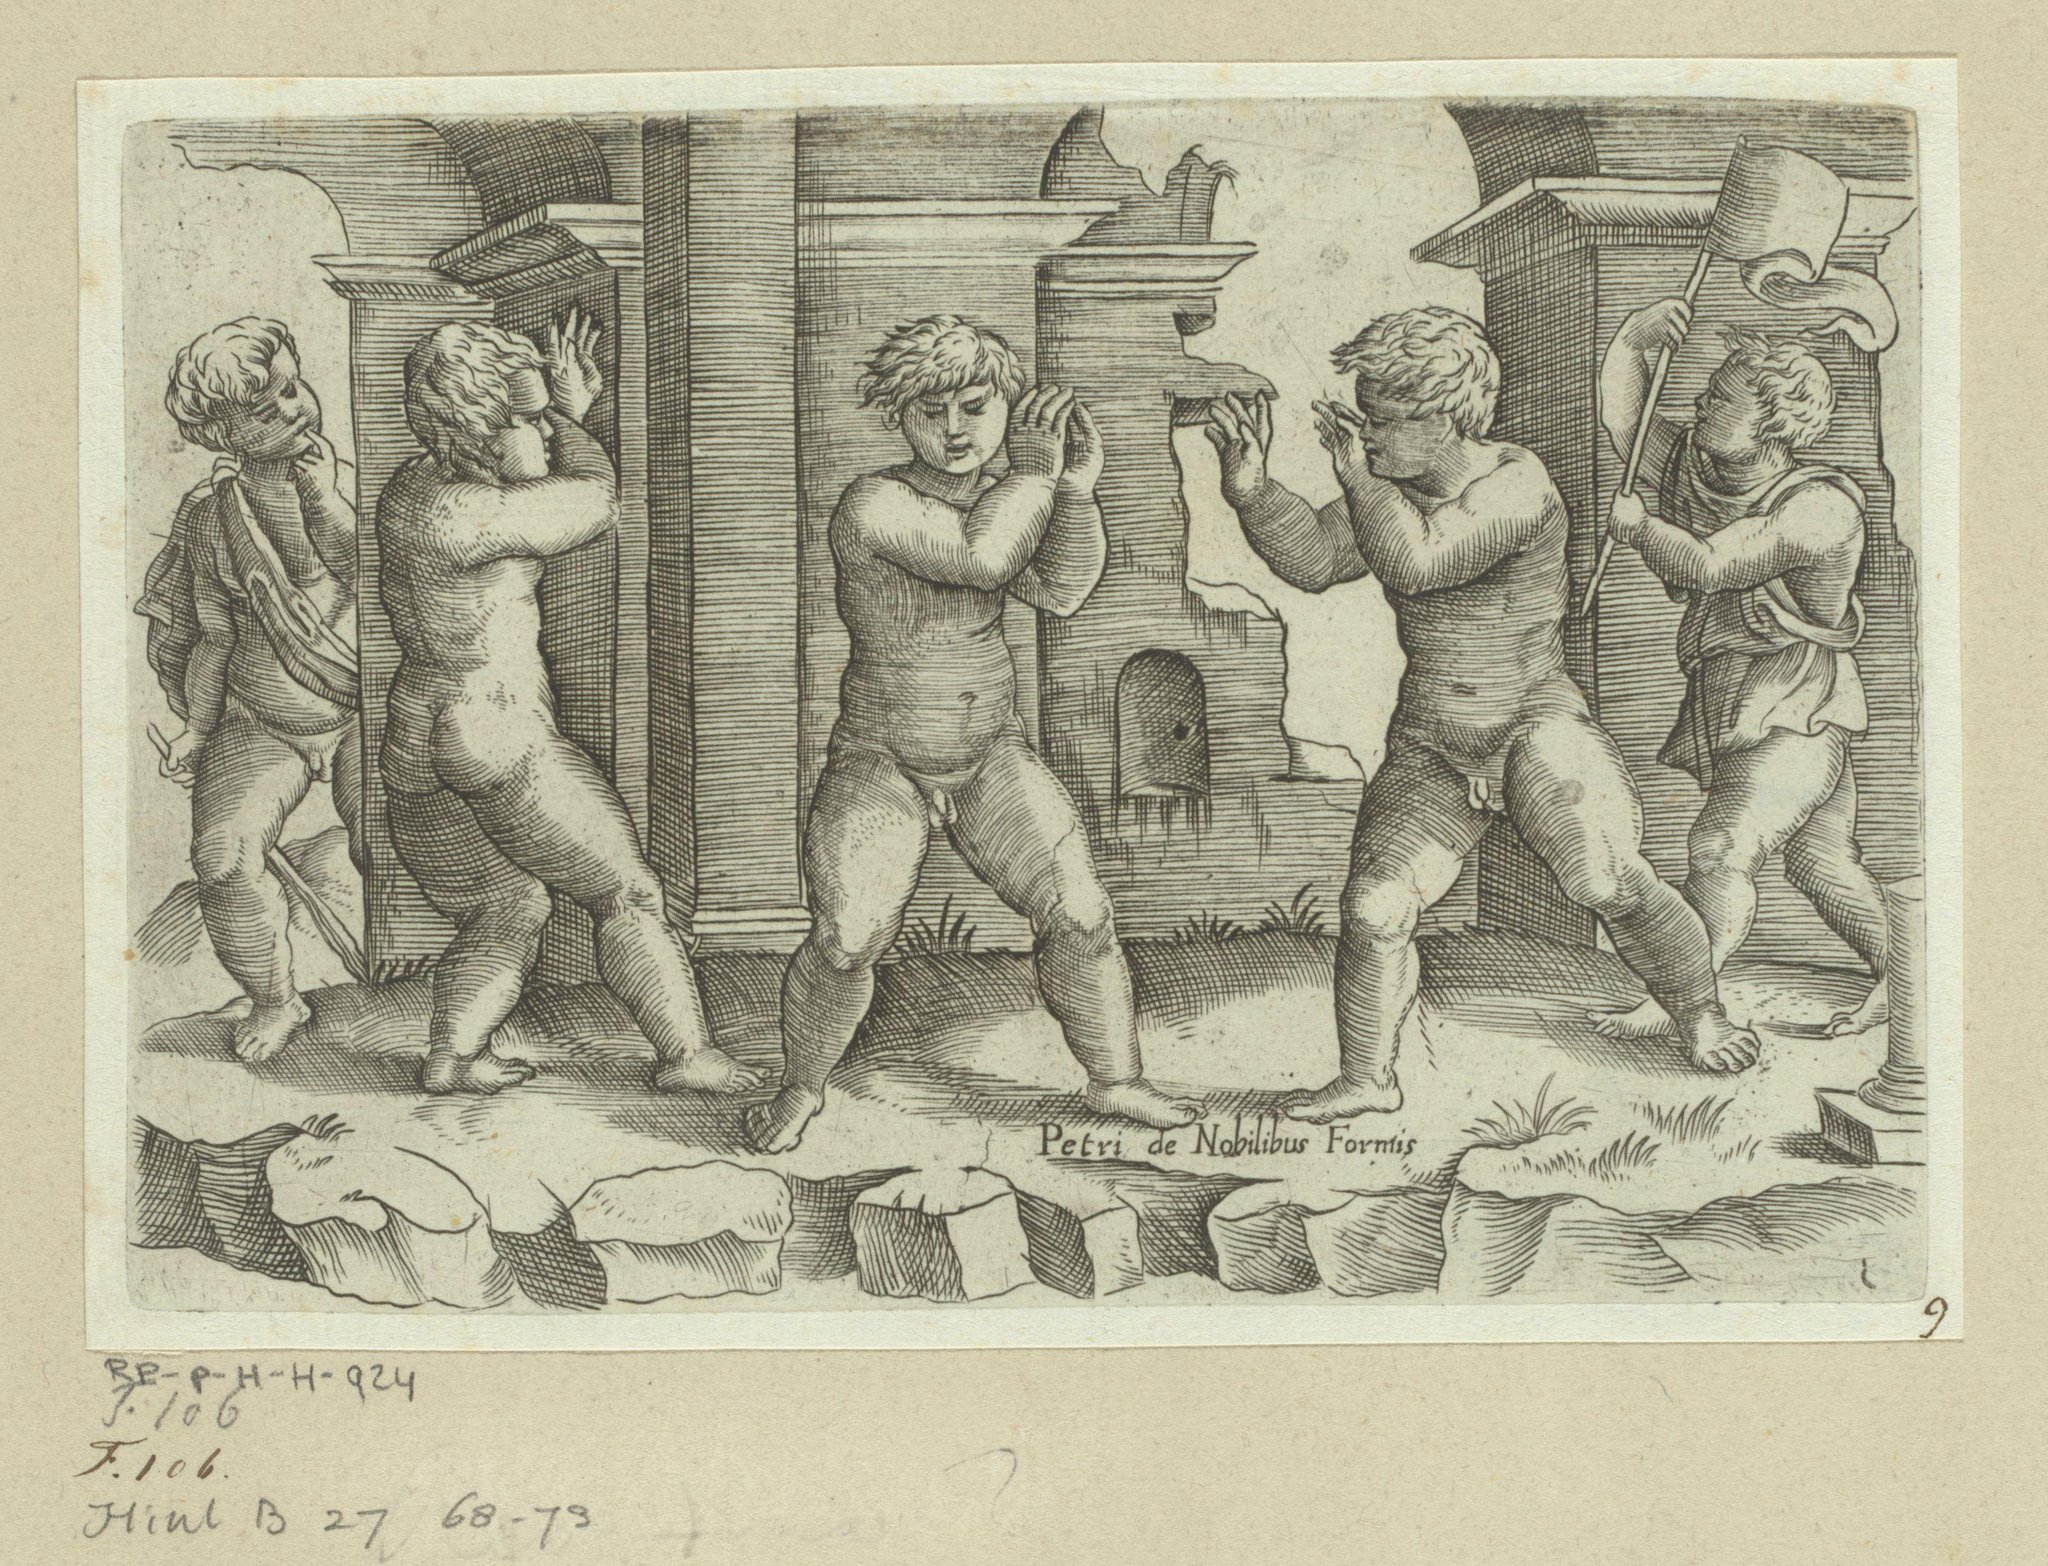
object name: print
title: Vijf putti bij een ruïne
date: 1500-1599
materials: paper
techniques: engraving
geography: italy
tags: ruin of a building ~ architecture, cupids: 'amores', 'amoretti', 'putti'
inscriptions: collector's mark: Lugt 10, number: ‘9’, collector's mark: Lugt 11, collector's mark: ‘Hinloopen’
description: Vijf spelende putti voor een antieke ruïne. De rechter putto houdt een vlag in de hand.